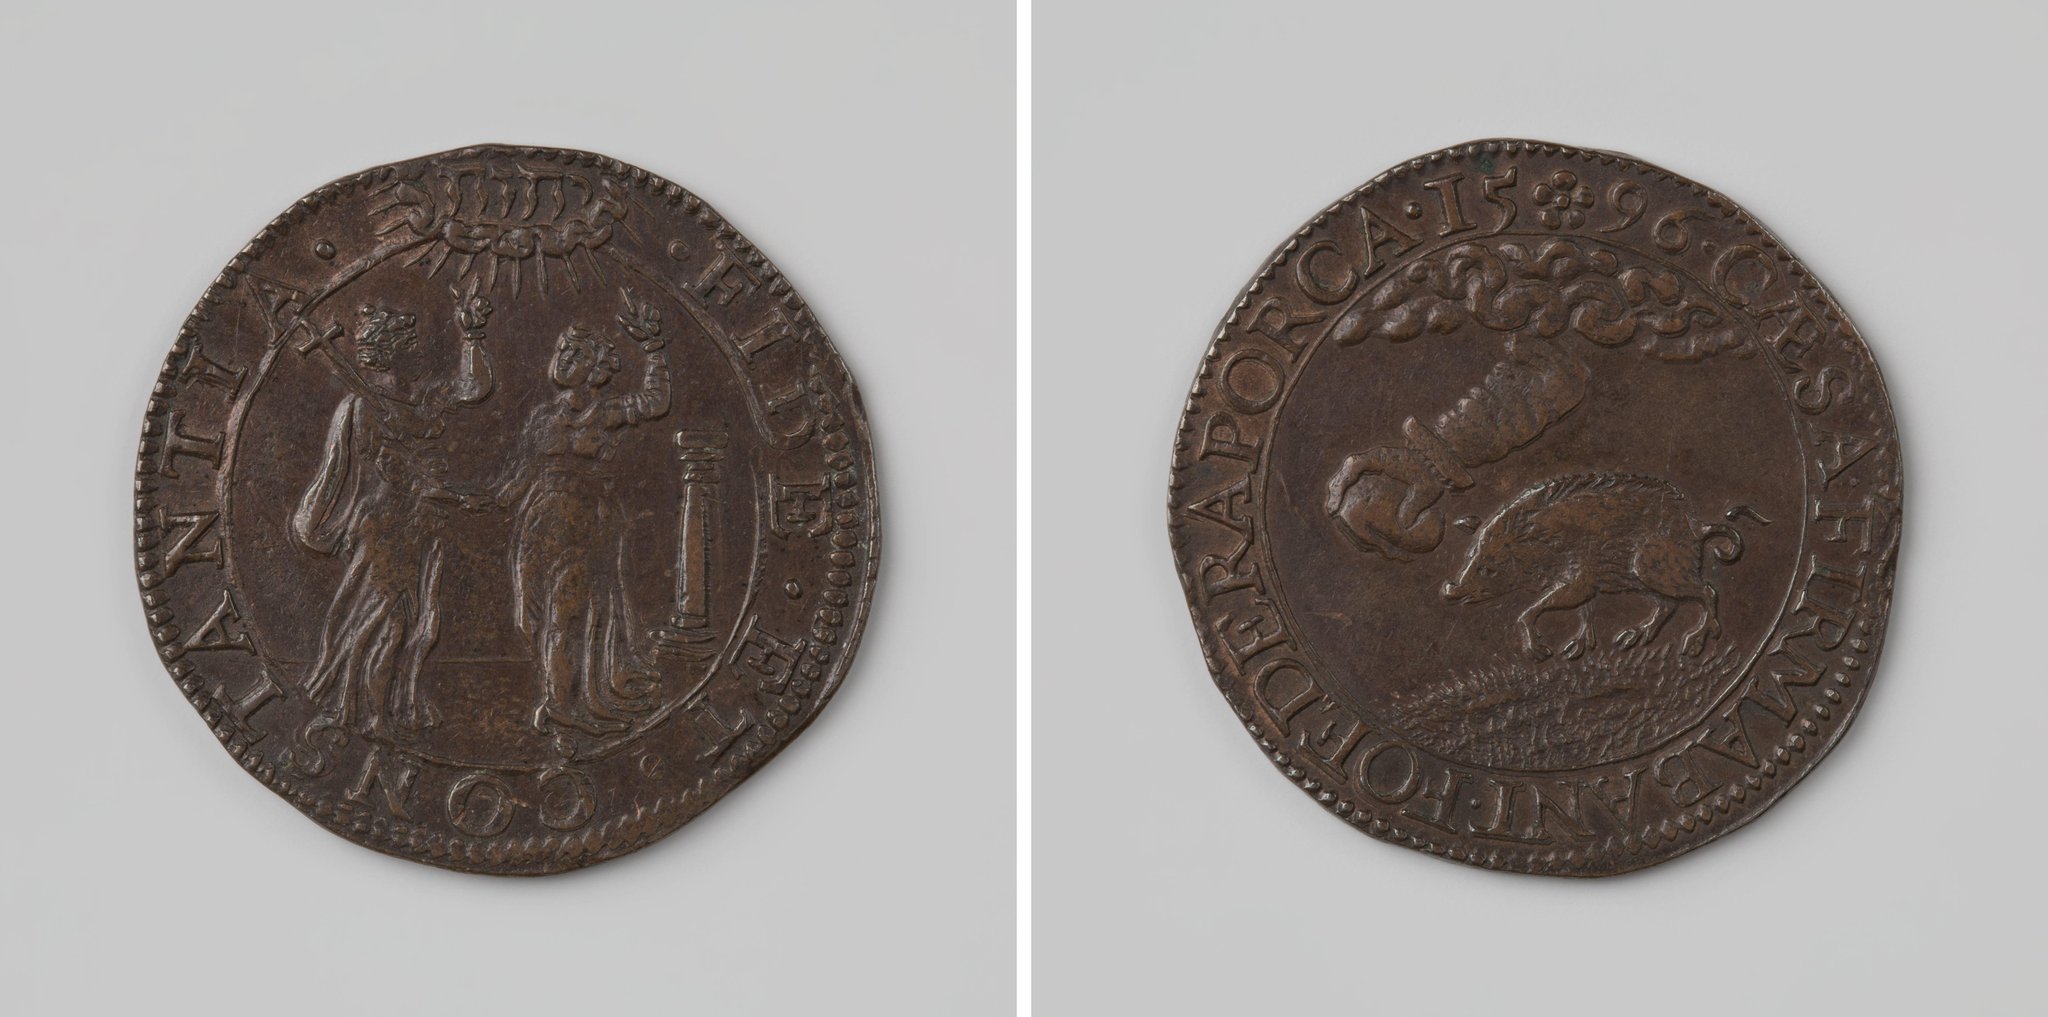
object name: jeton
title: Sluiting van het drievoudige verbond tussen Engeland, Frankrijk en de Republiek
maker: Anonymous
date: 1596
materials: copper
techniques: striking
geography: dordrecht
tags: netherlands, france, england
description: Koperen penning. Voorzijde: beschenen door hemellicht met daarin naam Jehova in Hebreeuws schrift geven Geloof met kruis en Standvastigheid, staande voor zuil, elkaar hand binnen omschrift. Keerzijde: zwijn; daarboven: arm uit wolken met kei in hand binnen omschrift.